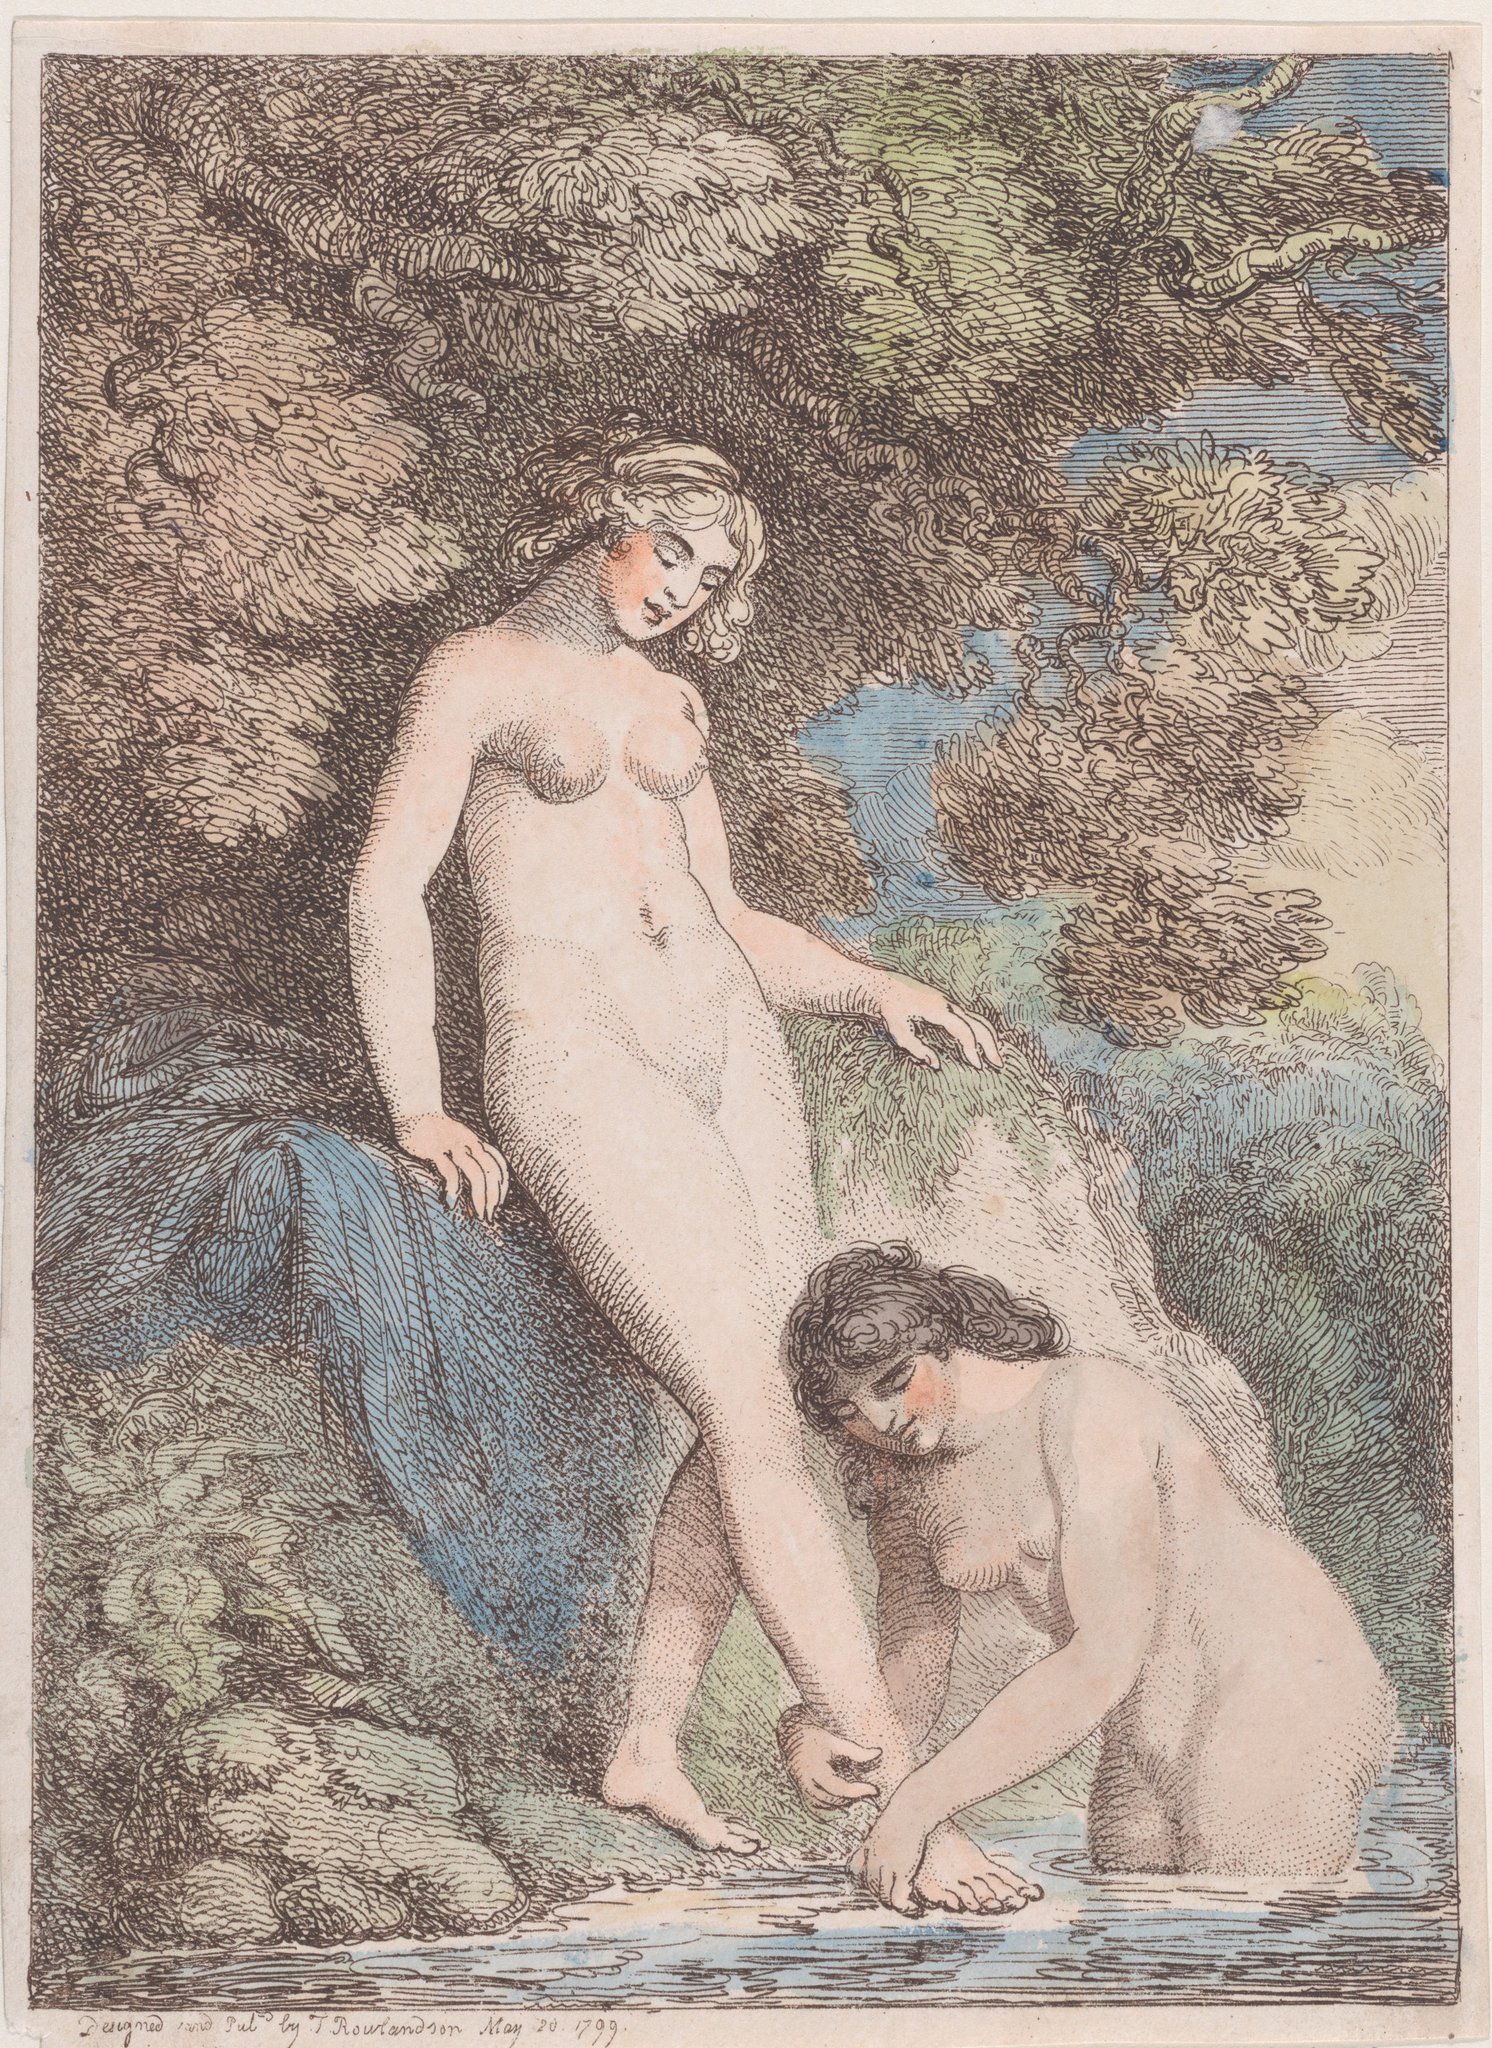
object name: print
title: Two Nymphs Bathing, One Washing the Other's Foot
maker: thomas rowlandson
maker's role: artist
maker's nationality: british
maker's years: 1757-1827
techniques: etching, stippling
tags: female nudes,nymphs